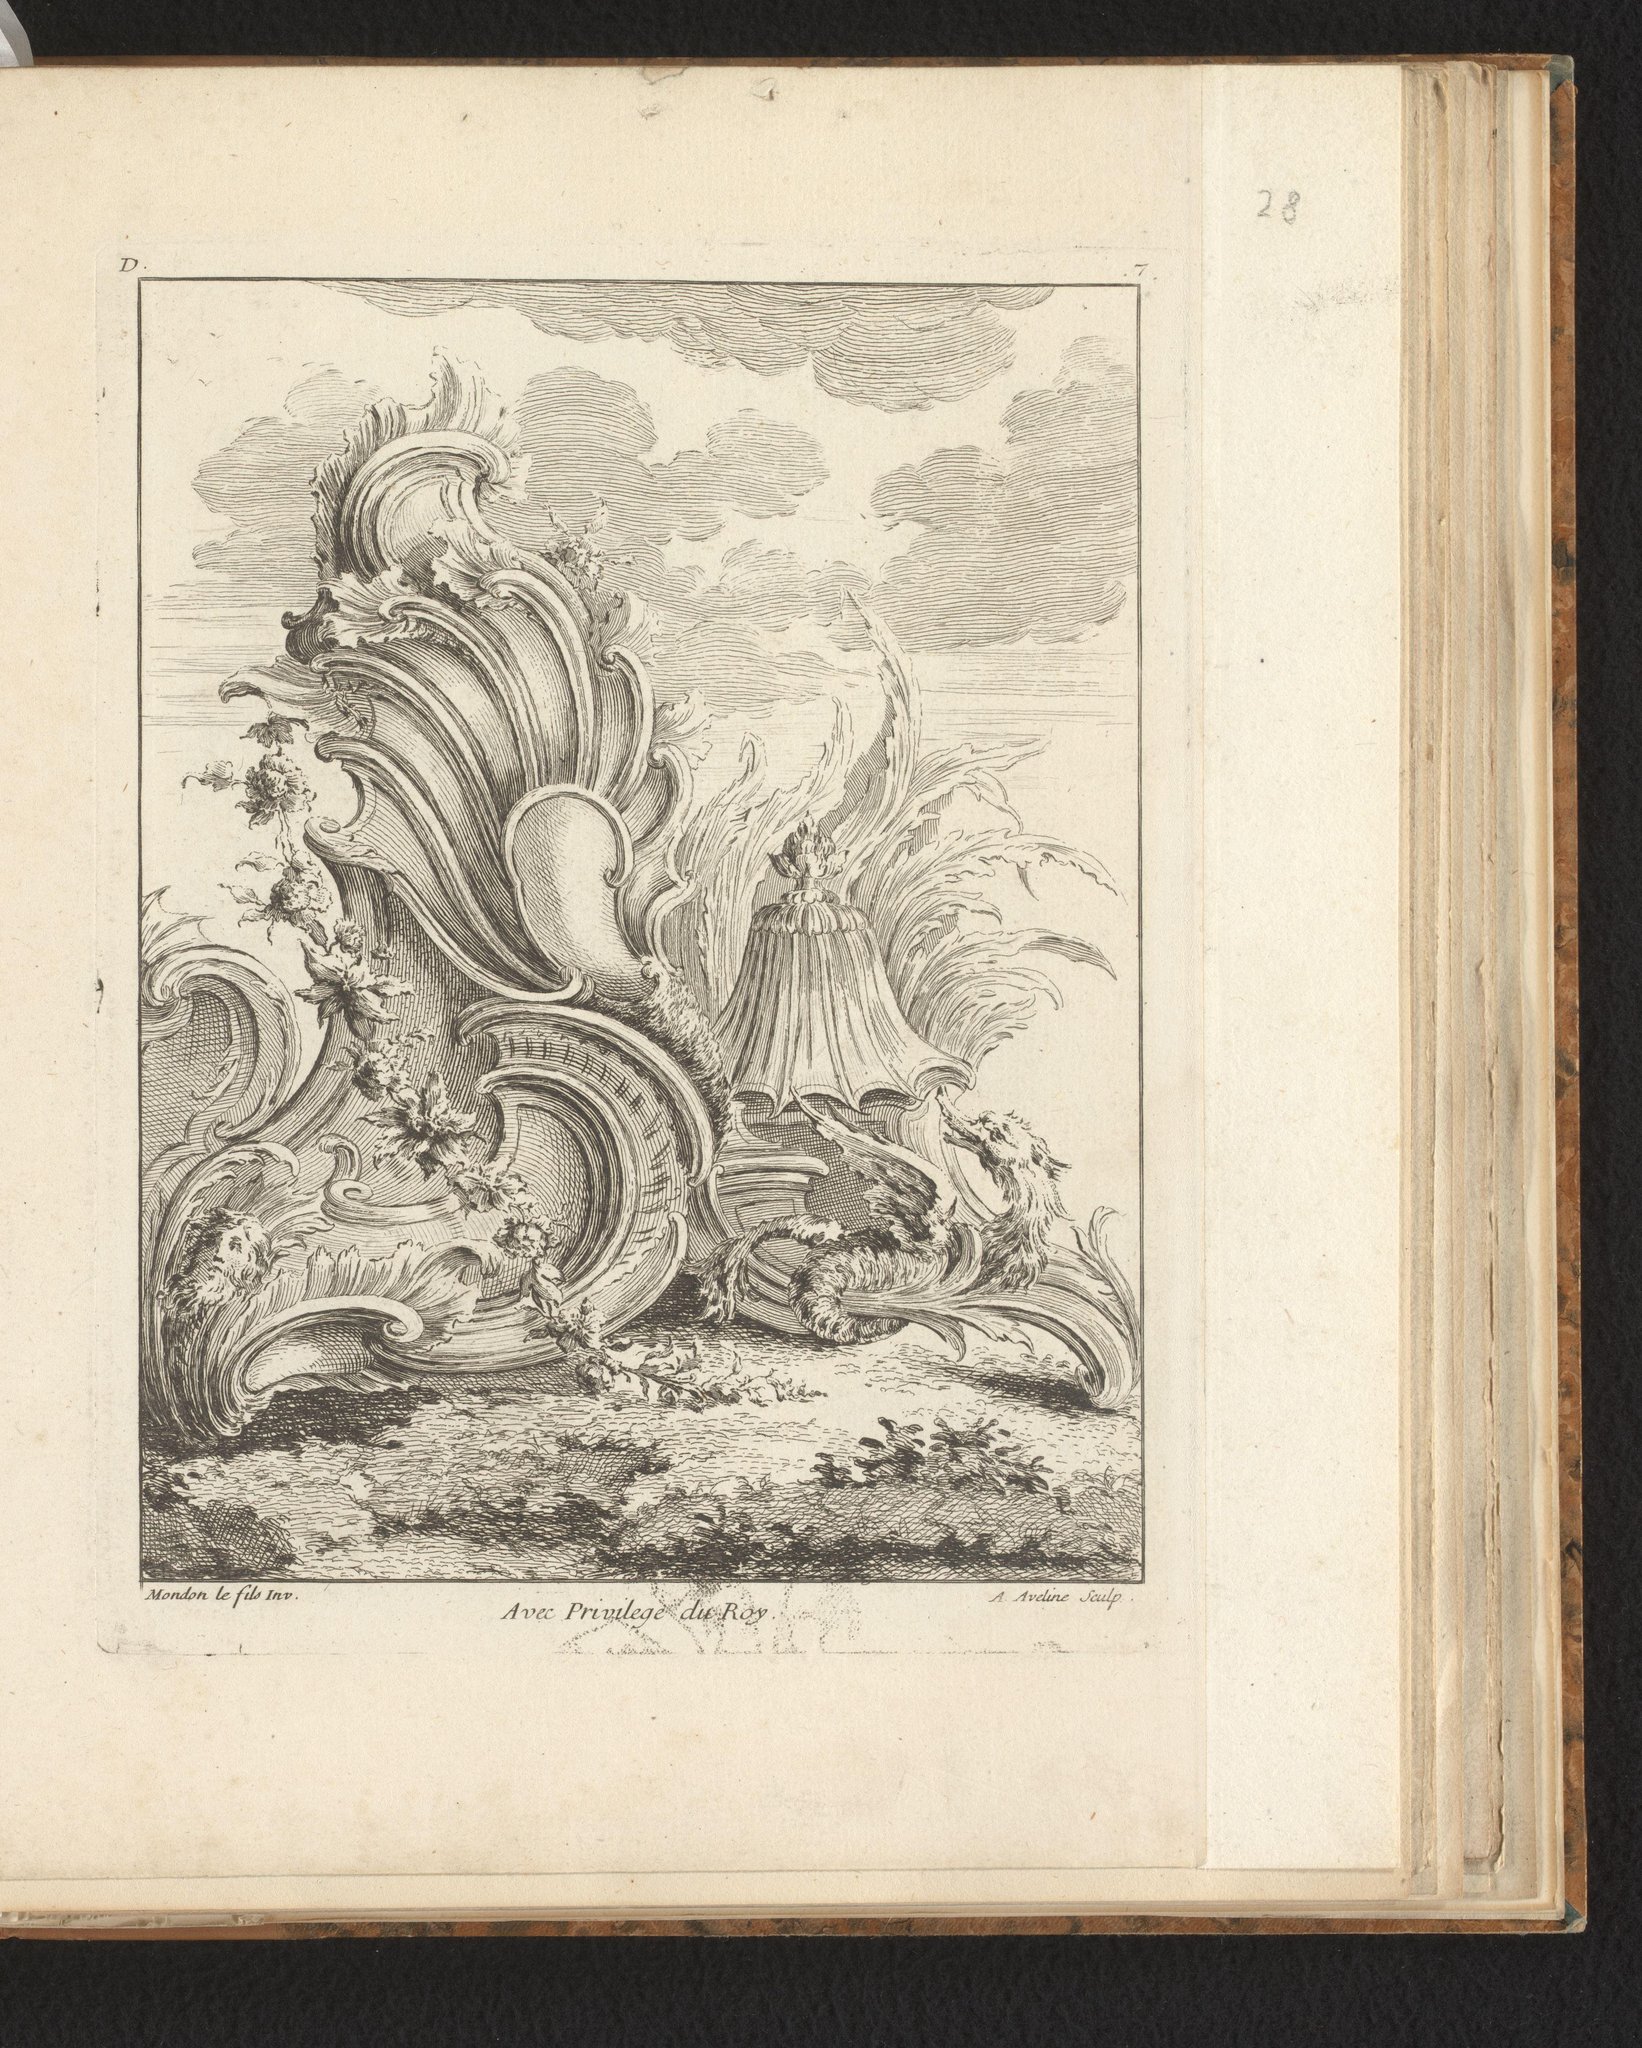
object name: ornament print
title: Quatrième Livre de Formes ornées de Rocailles (...) et Dragons Chinois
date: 1736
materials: paper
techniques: etching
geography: france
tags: rocaille ornament, dragon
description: Deze serie is linksboven genummerd met een letter D. Prent maakt deel uit van een album.